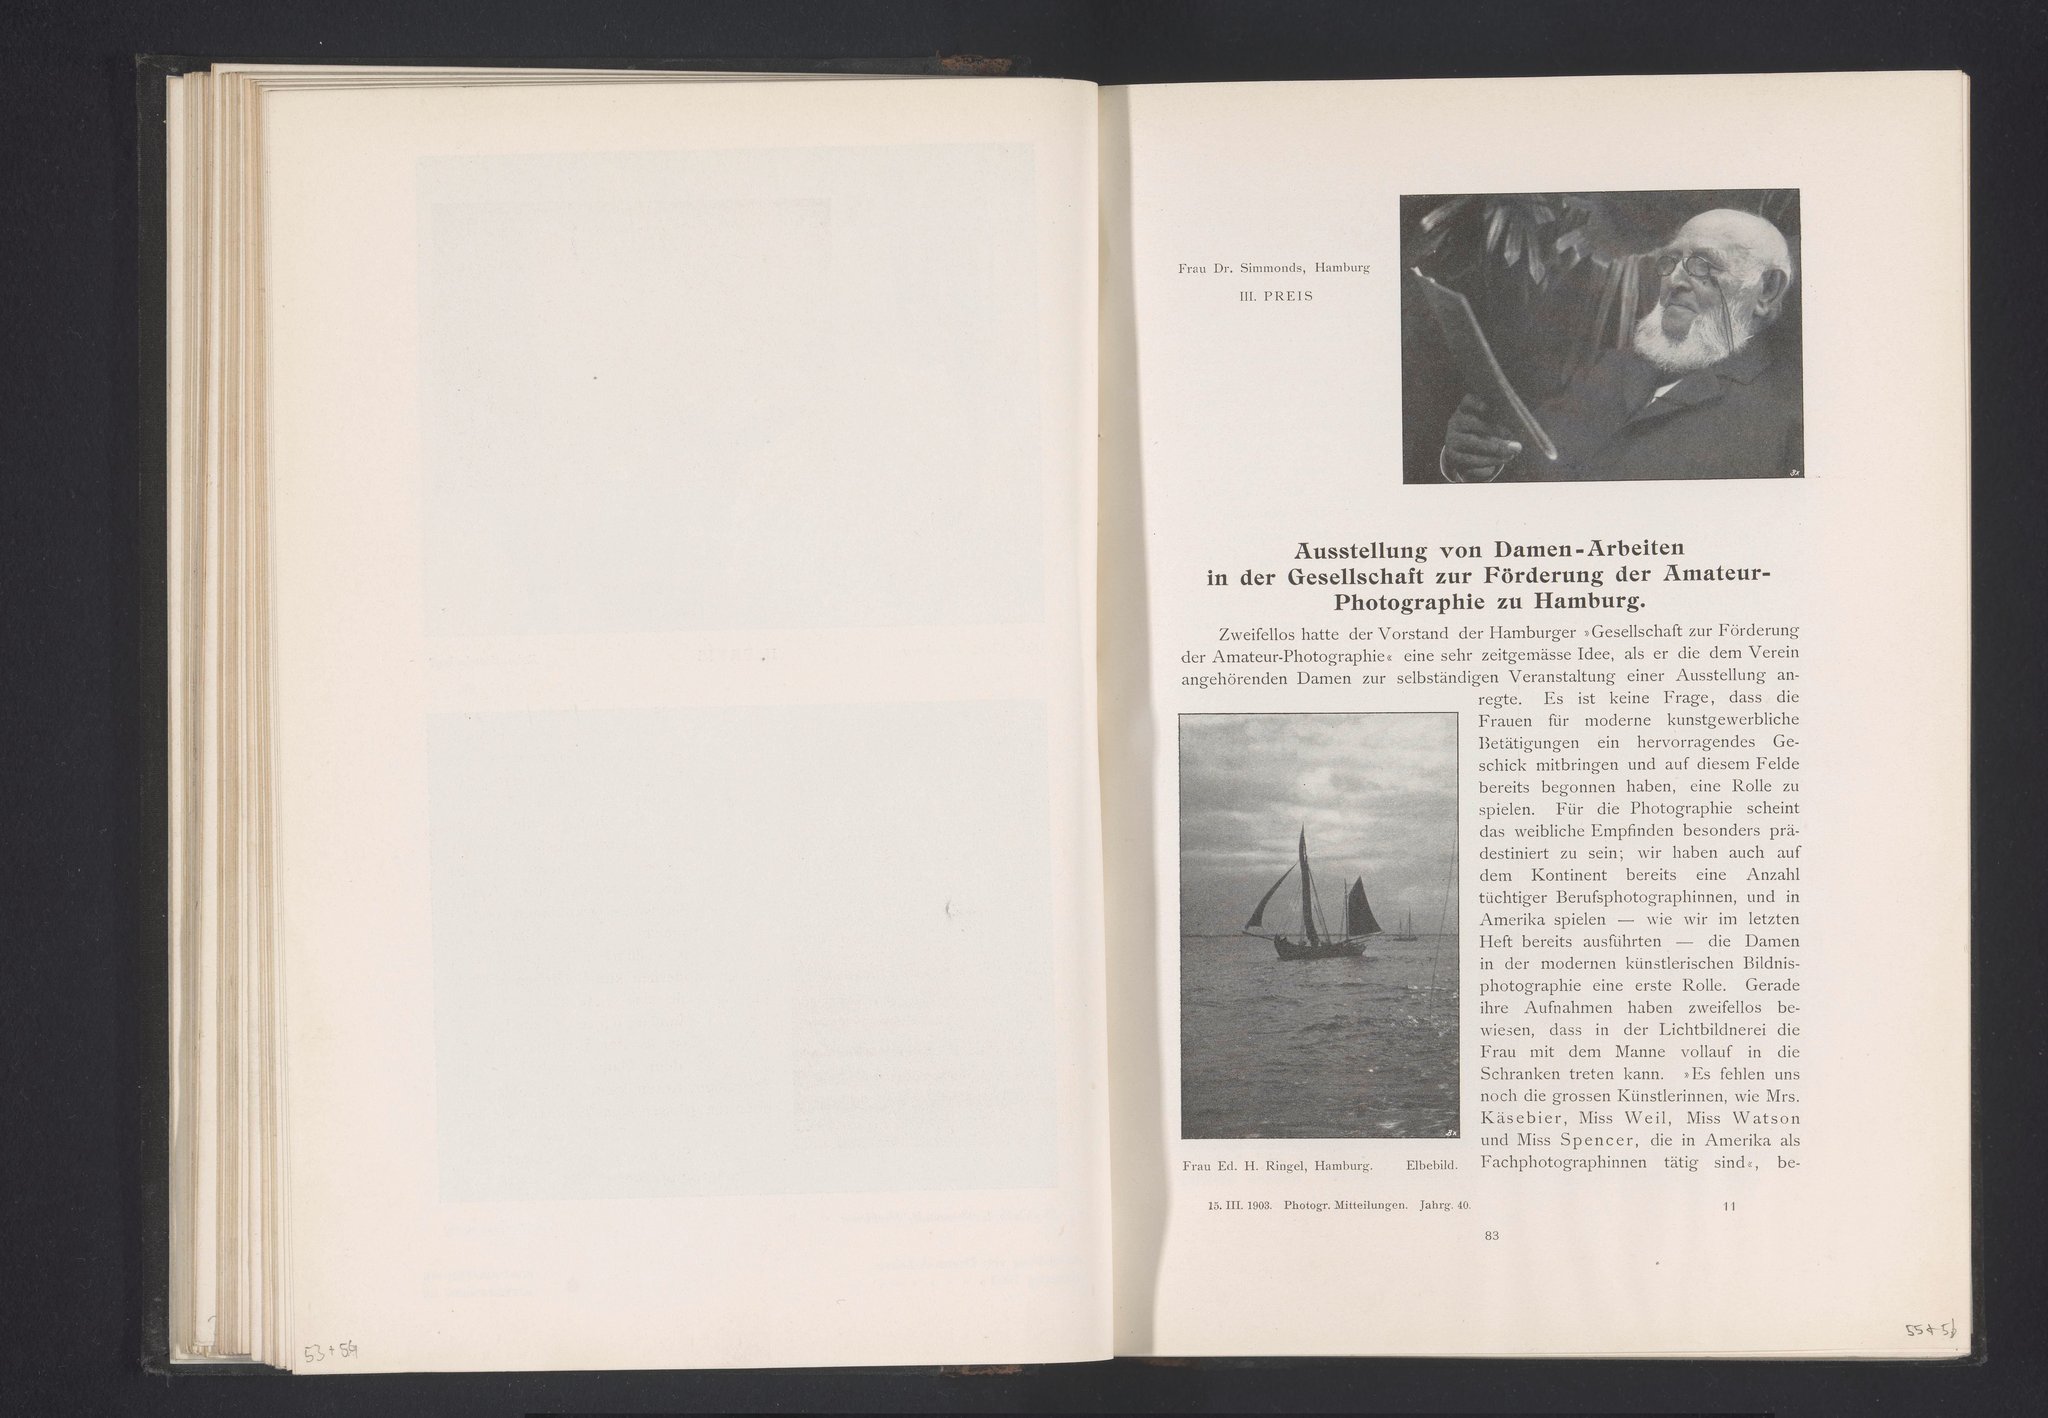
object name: photomechanical print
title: Elbebild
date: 1898-1903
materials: paper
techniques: autotype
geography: elbe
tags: sailing-ship, sailing-boat, river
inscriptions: monogram: ‘BX’, inscription: ‘Hamburg’